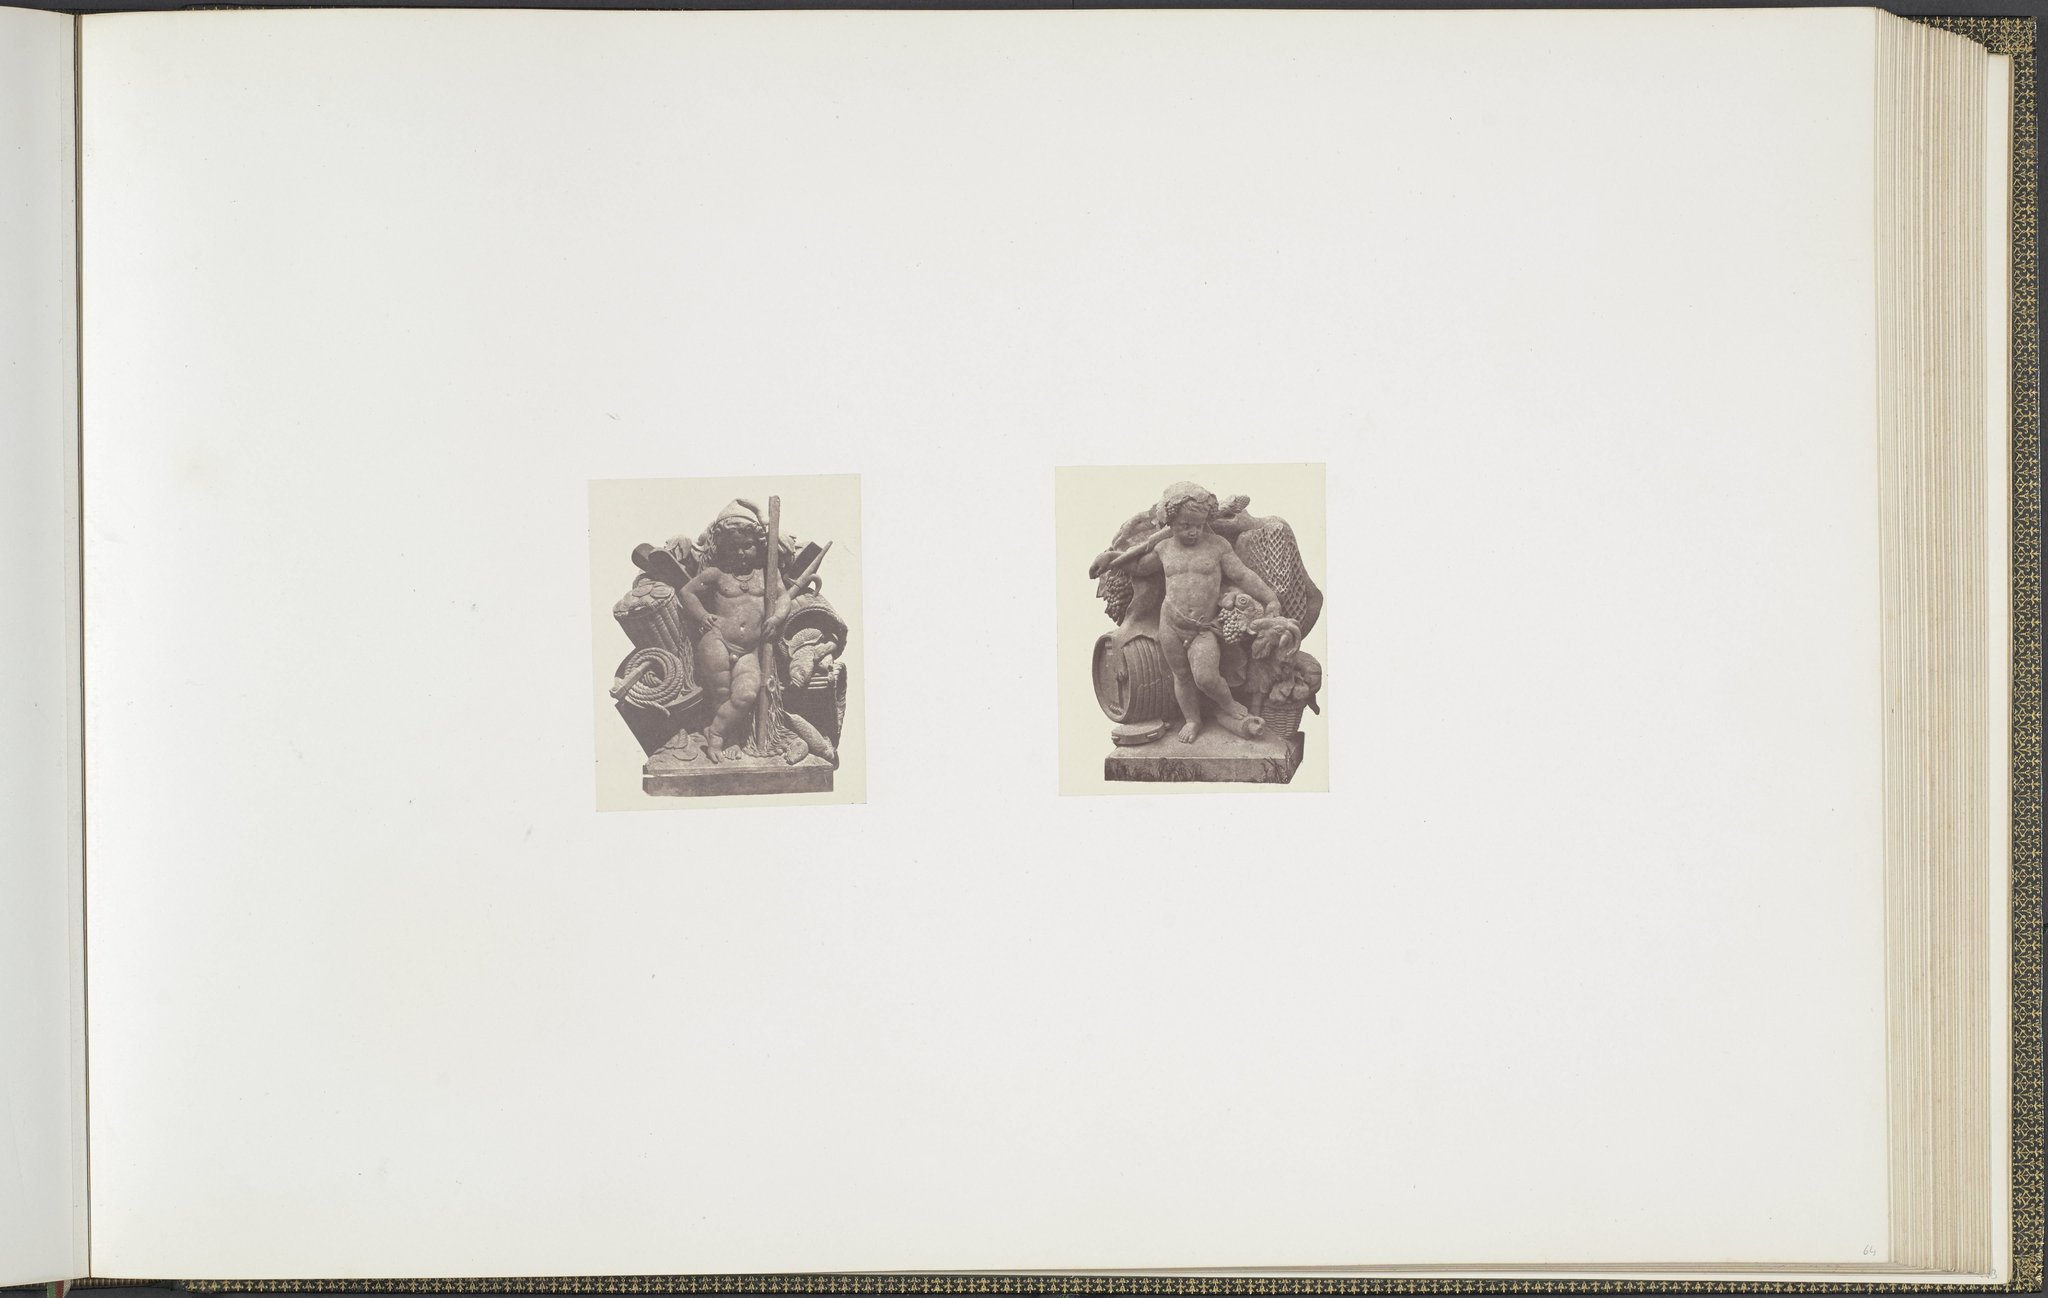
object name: photograph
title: Gipsmodellen voor beeldhouwwerken op het Palais du Louvre: links "La Pêche"door Aimé-Napoléon Perrey en rechts "L'Automne" door Félix Chabaud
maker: édouard denis baldus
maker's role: fotograaf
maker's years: 1813-1889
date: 1855-1857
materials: paper, photographic support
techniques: salted paper print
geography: paris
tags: piece of sculpture, reproduction of a piece of sculpture, permanent exhibition, museum, paris, tuileries palace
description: Onderdeel van Réunion des Tuileries au Louvre 1852-1857, album 1.